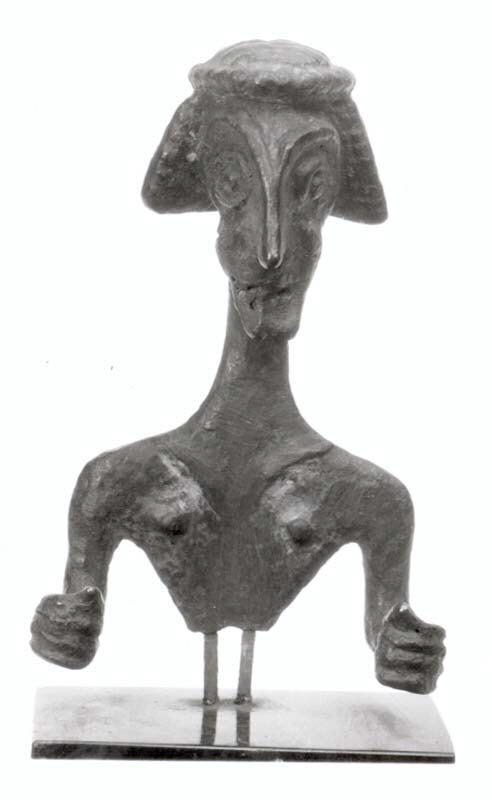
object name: sculpture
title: Figure fragment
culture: canaanite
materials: bronze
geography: syria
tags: faces